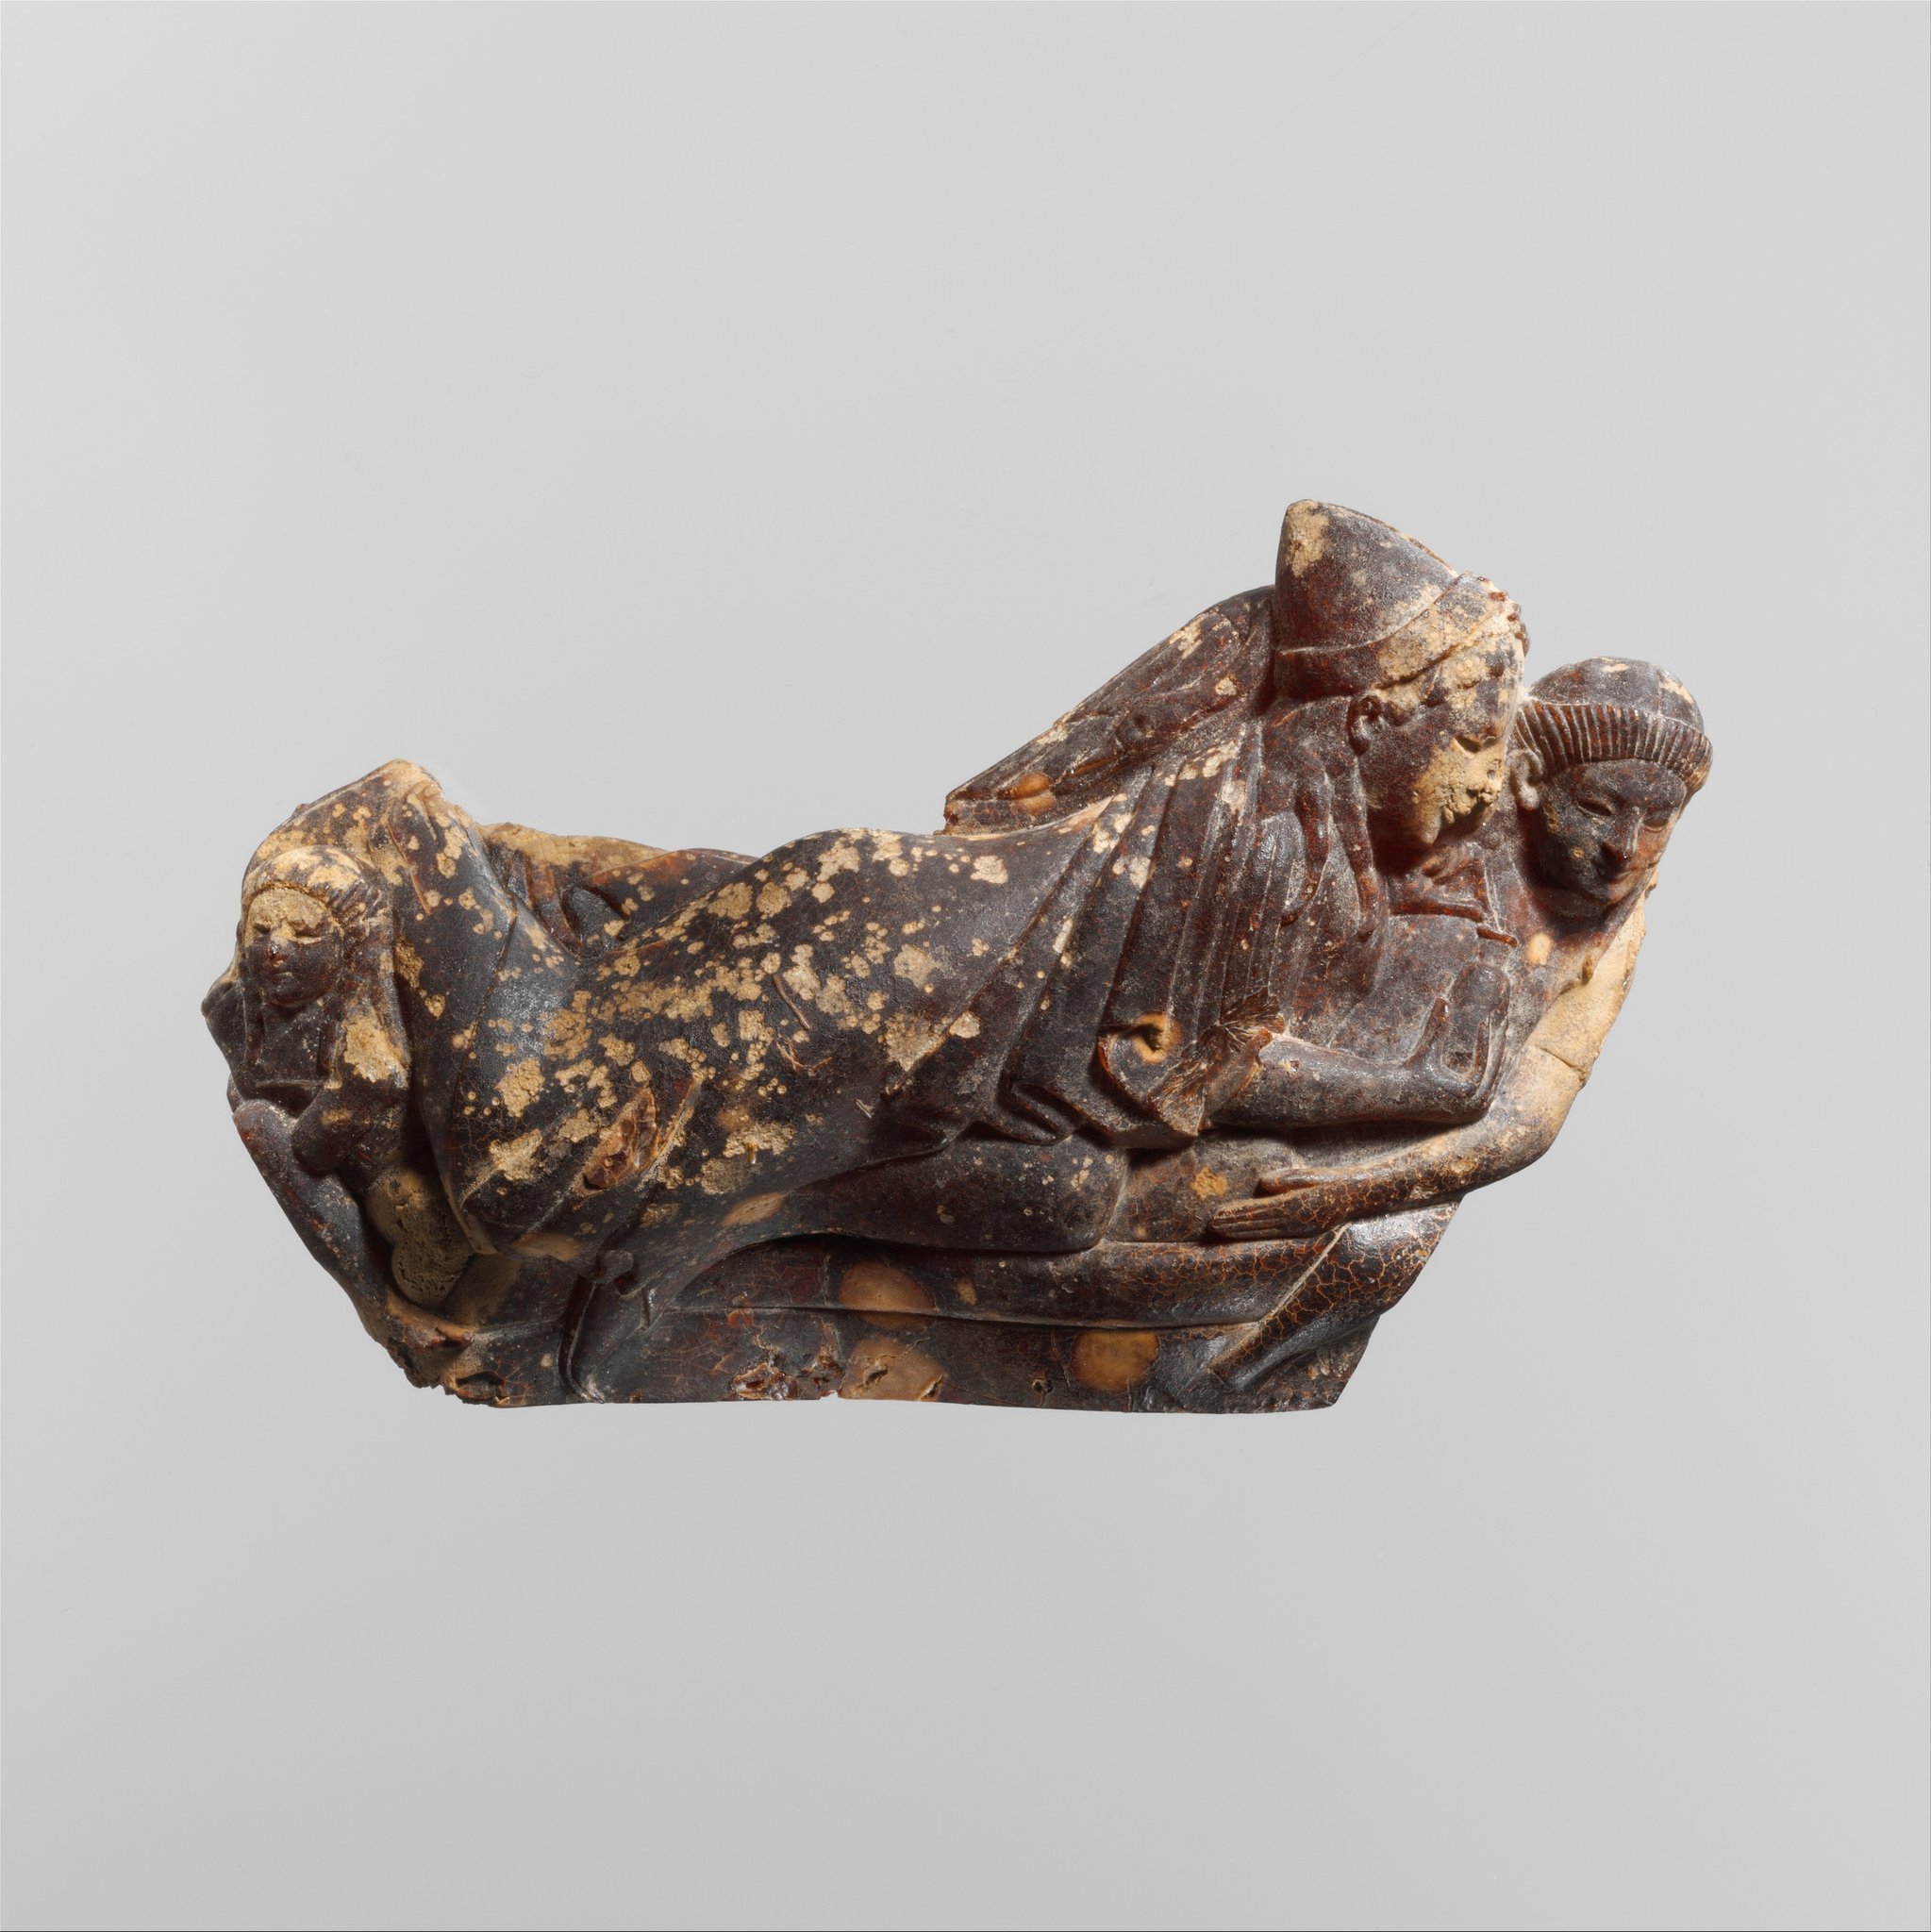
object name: relief of a woman and youth reclining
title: Carved amber bow of a fibula (safety pin)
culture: etruscan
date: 500 BCE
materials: amber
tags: couples,men,women